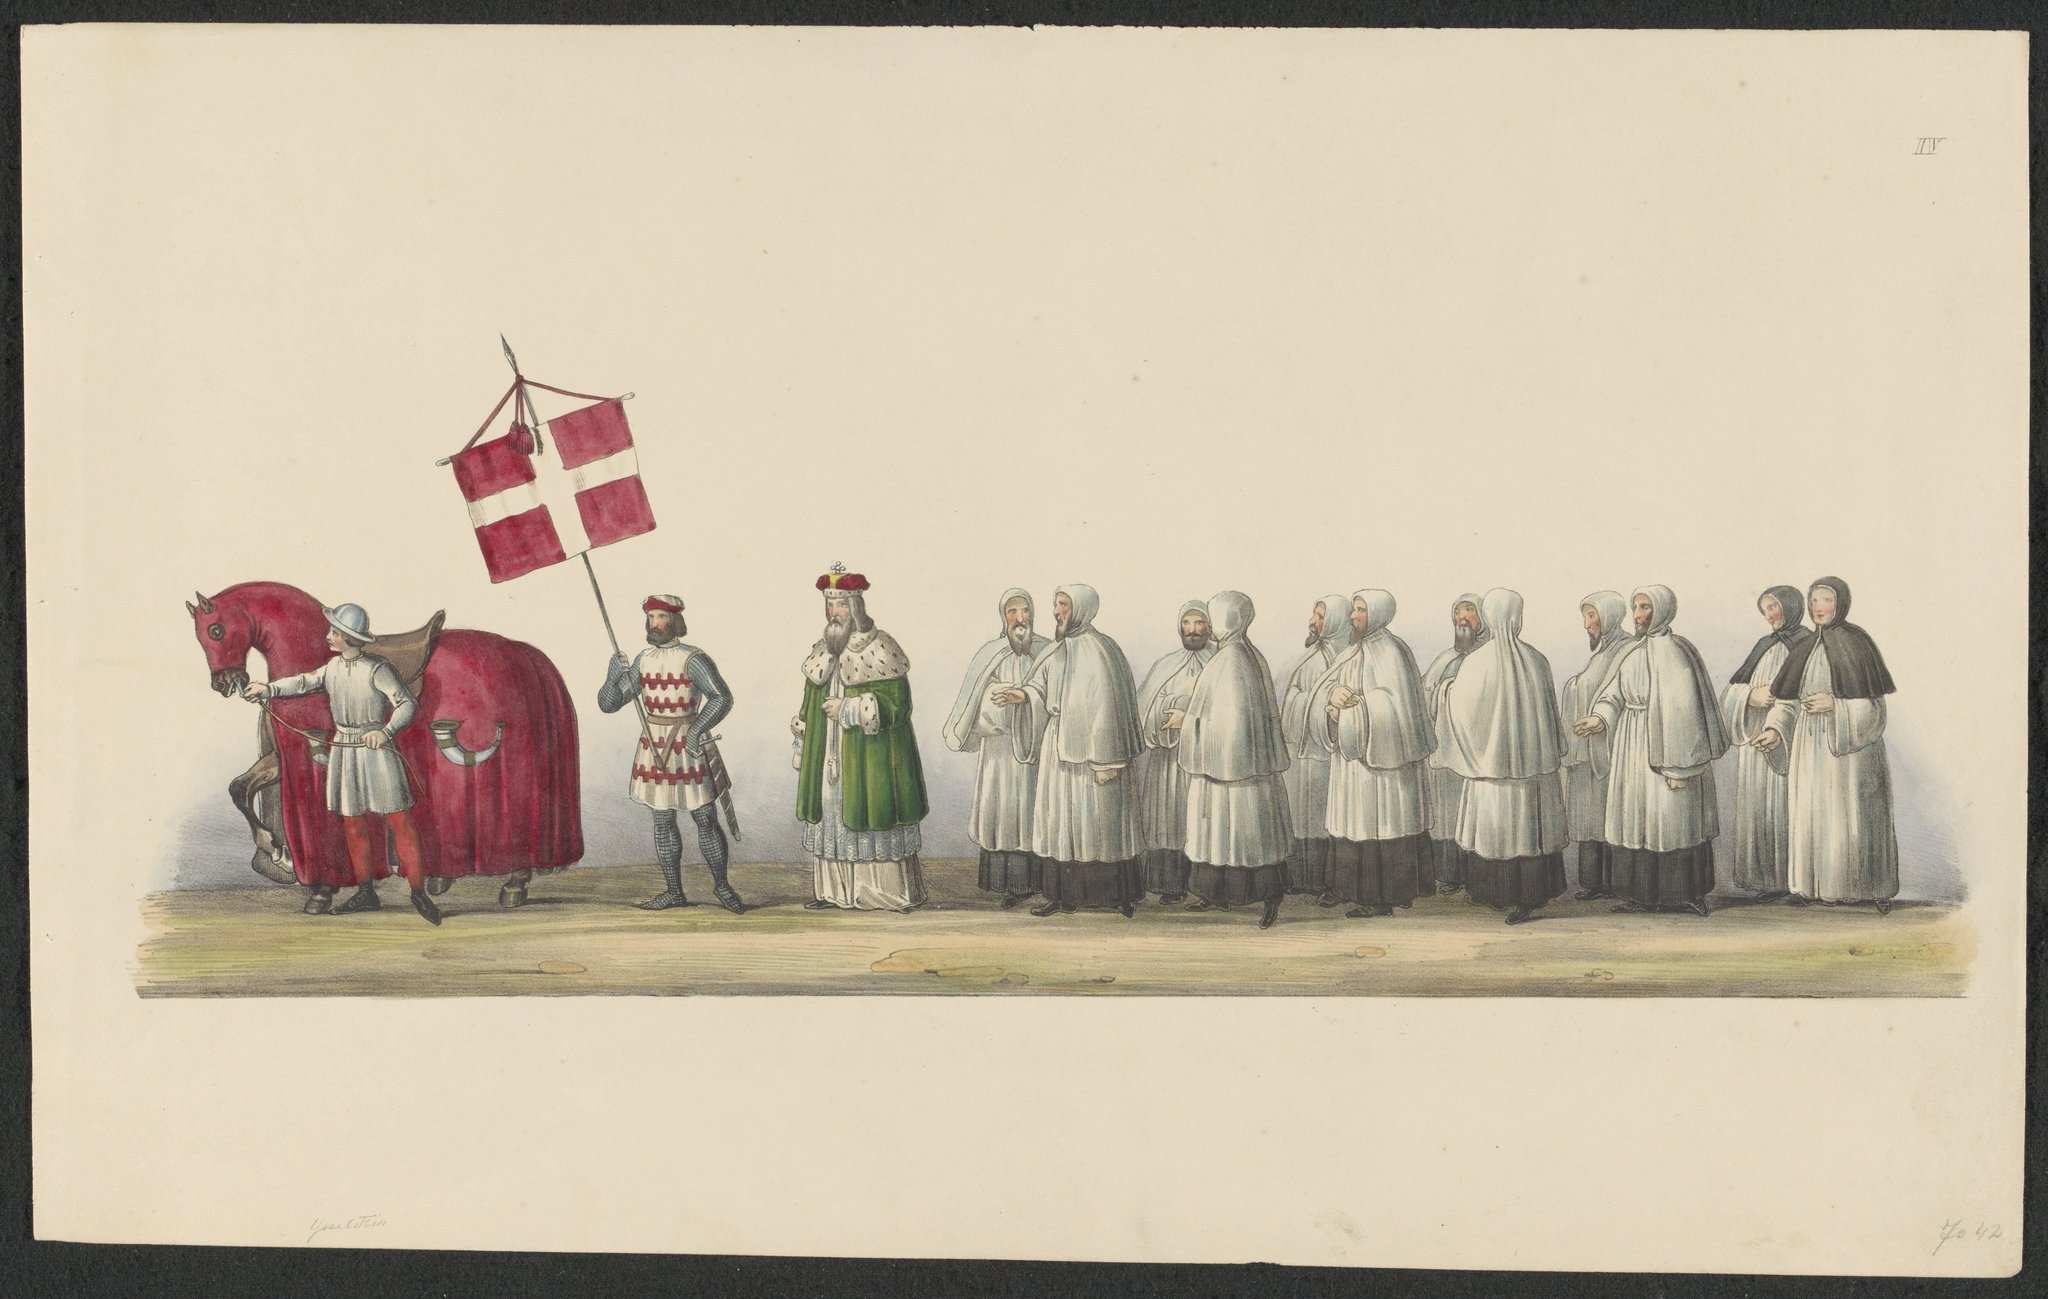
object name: print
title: Gekostumeerde optocht van 1841: koning en geestelijken (blad IV)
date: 1841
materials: paper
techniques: hand coloring, lithograph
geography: leiden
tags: earl, students' pageant, costumes used in pageants, utrecht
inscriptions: collector's mark: Lugt 2228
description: Een paard zonder ruiter, een koning gevolgd door een groep geestelijken in witte of grijze mantels. Blad genummerd IV in de serie van achttien platen van de historische gekostumeerde optocht voorstellende de ontvangst van graaf Willem II van Holland in Utrecht in 1249. De optocht gehouden door de studenten van de Universiteit van Utrecht op 2 juni 1841 ter gelegenheid van de viering van het vijfentwintigjarige herstel van de Hogeschool.